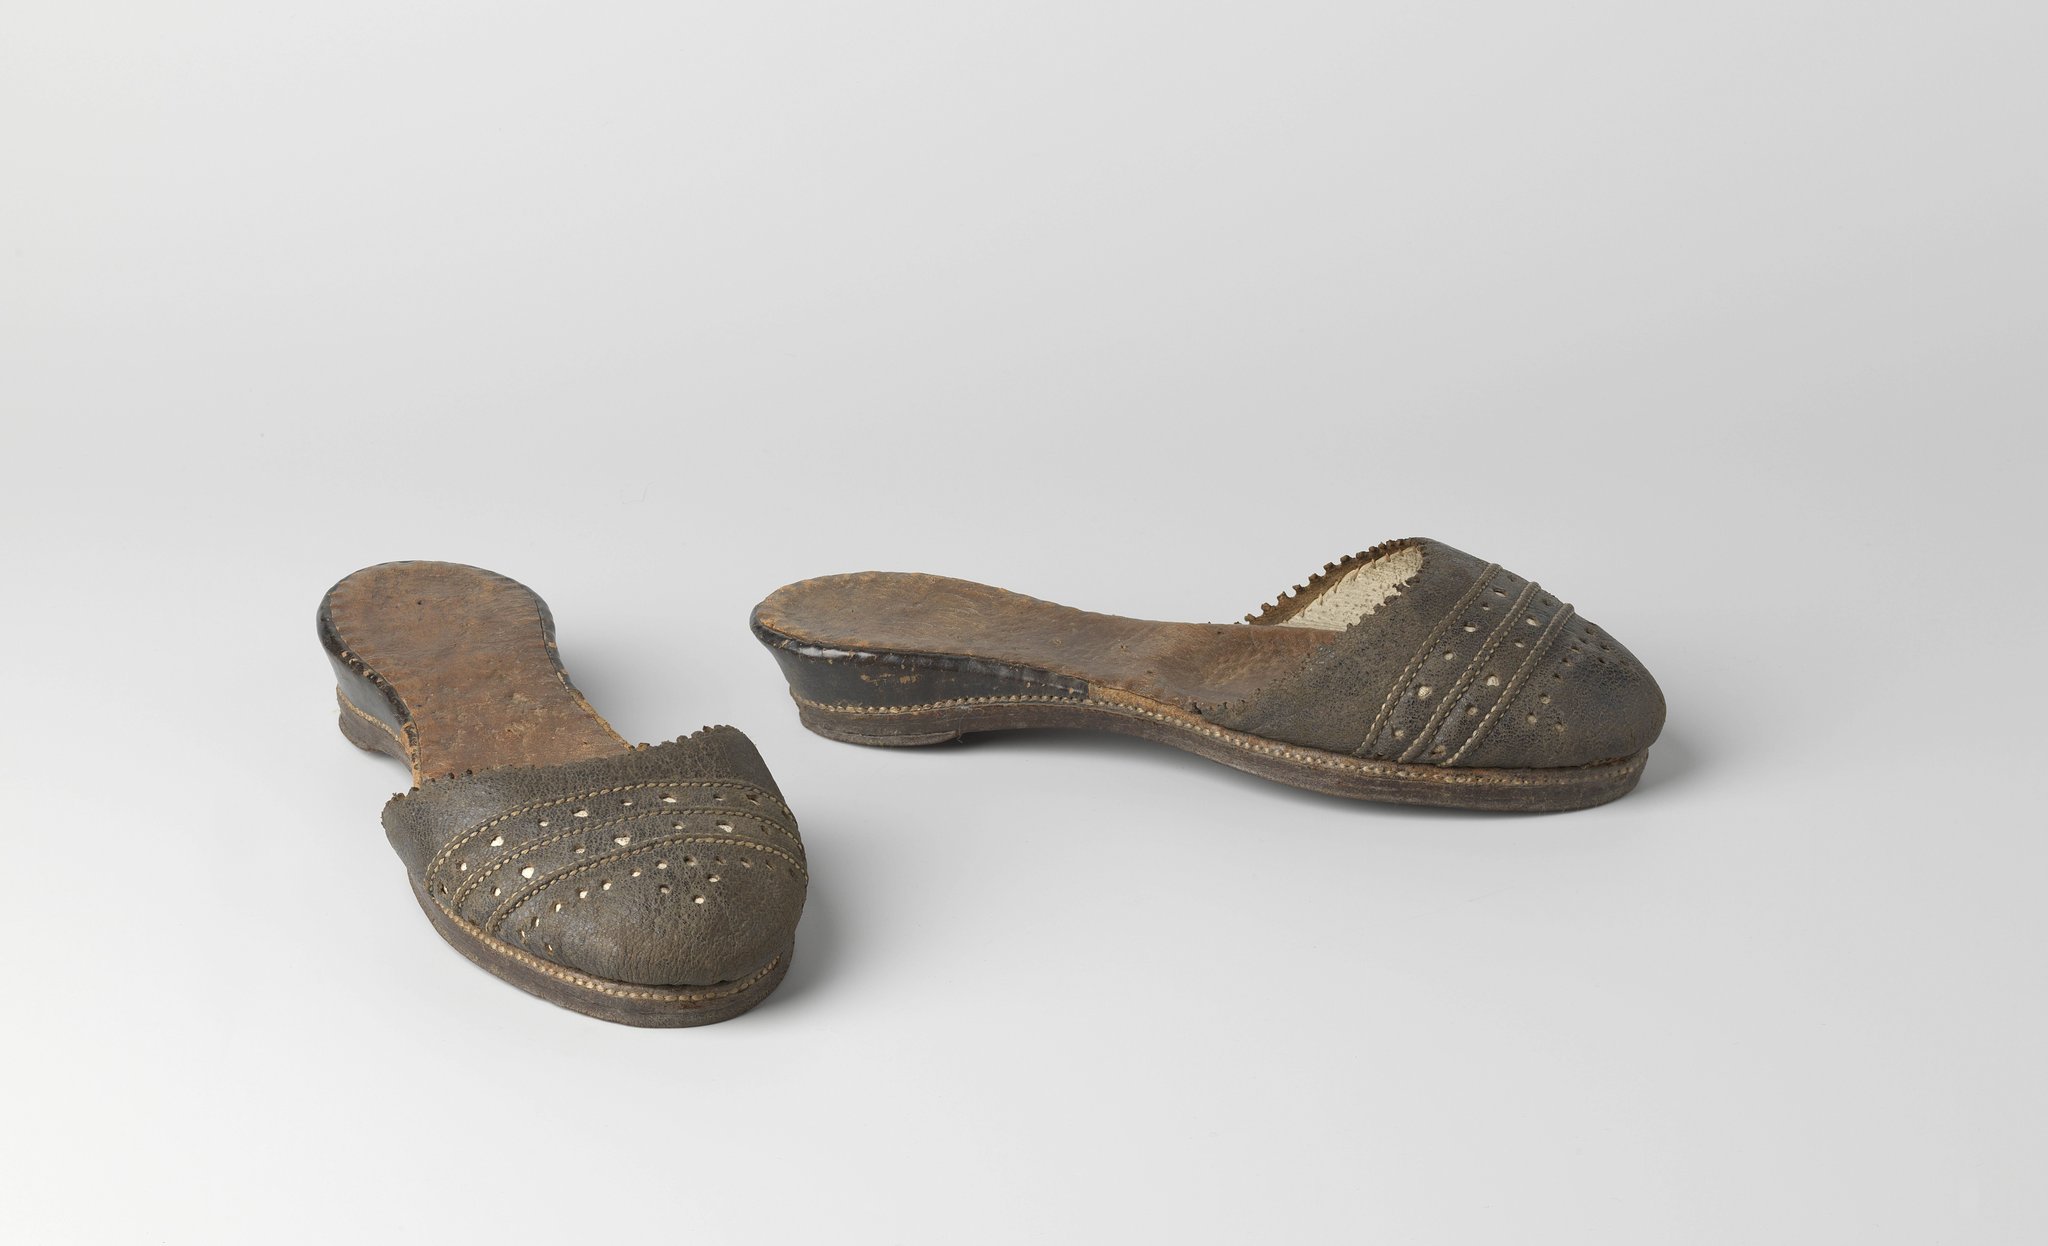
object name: womenswear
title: Muiltje van zwart leer met lage sleehak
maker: Anonymous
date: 1600-1650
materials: leather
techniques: perforating, stitching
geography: northern netherlands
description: Een paar vrouwmuilen, links en rechts verschillend, ingebouwde lage hak. Smalle hiel, brede voorvoet, ronde neus; laag uitgesneden voorblad met witte stiksels en perforaties.